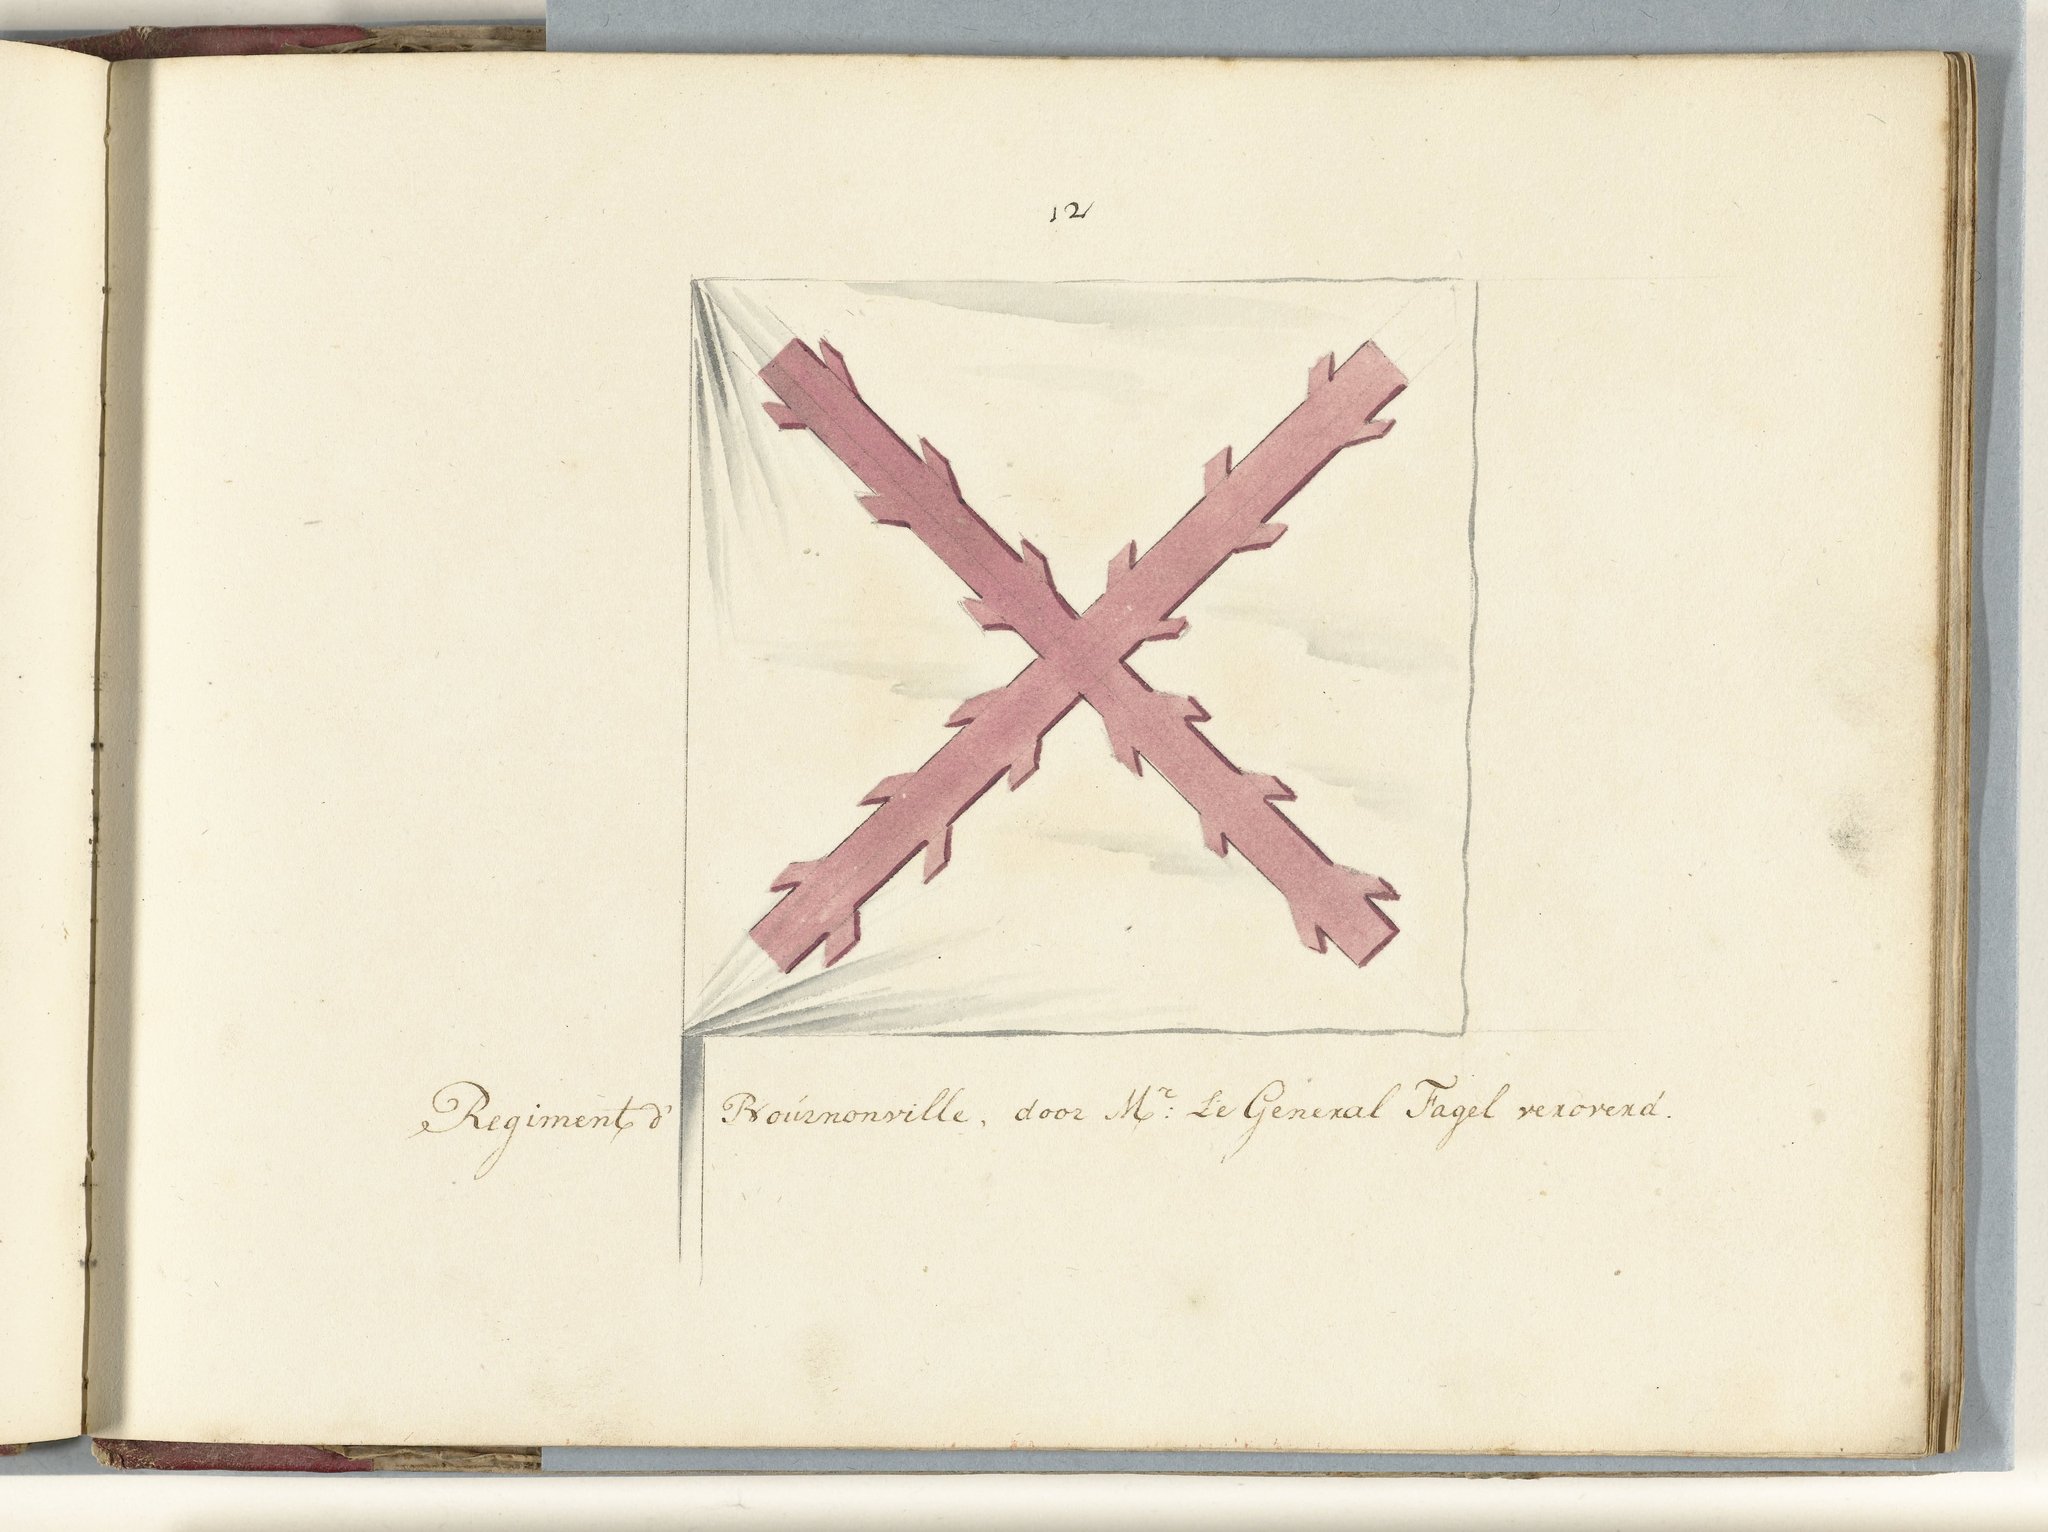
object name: drawing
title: Regiment d' Bournonville, door Mr. Le General Fagel veroverd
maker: Anonymous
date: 1713-1720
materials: paper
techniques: drawing, writing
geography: northern netherlands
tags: françois nicolaas fagel, (military) flags and standards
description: Frans vaandel veroverd bij de Schelde door in generaal François Nicolaas Fagel, 1701-1713. In het boek met tekeningen van Franse vaandels, standaarden en pauken, veroverd tijdens de Spaanse Successieoorlog (1701-1713).